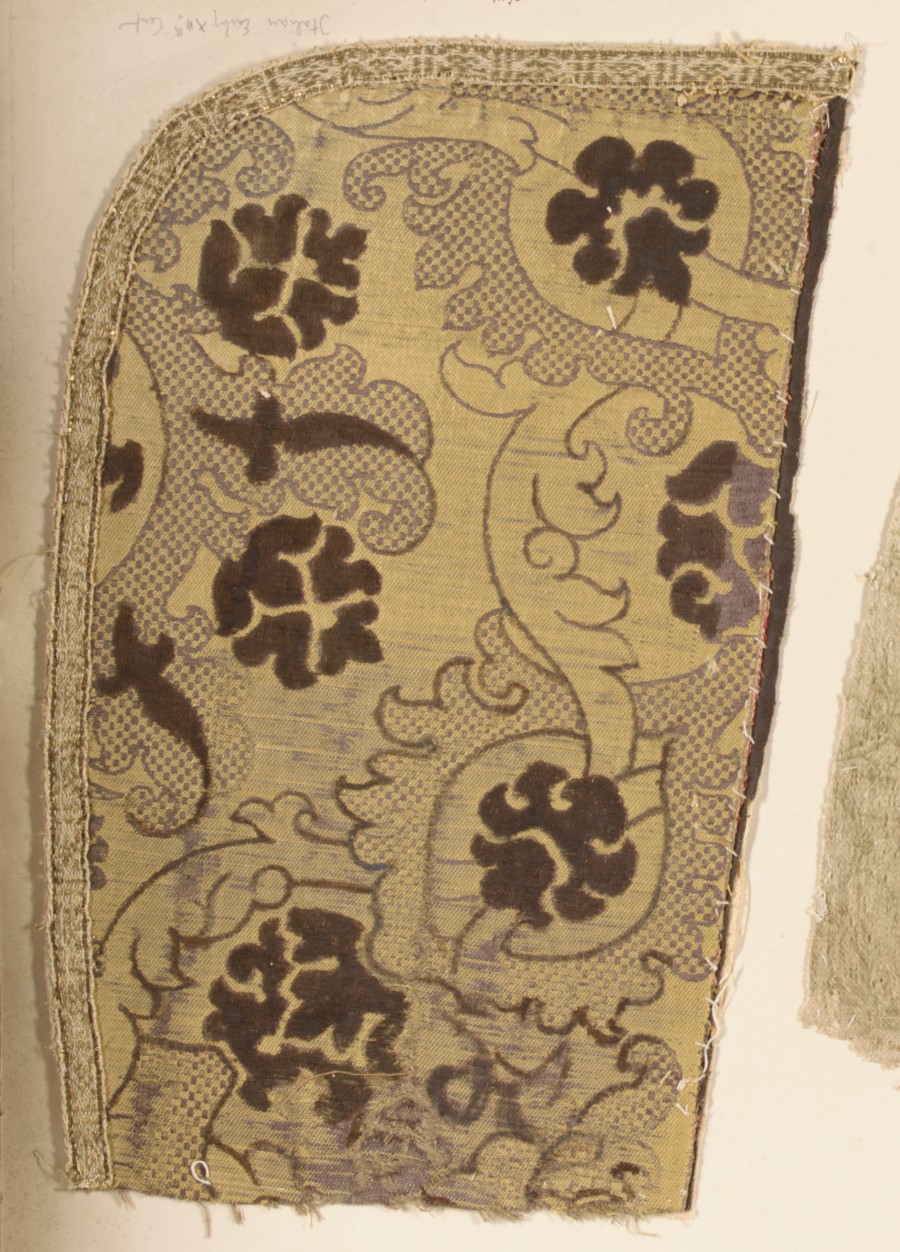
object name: fragment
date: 1501-1533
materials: metal thread, silk